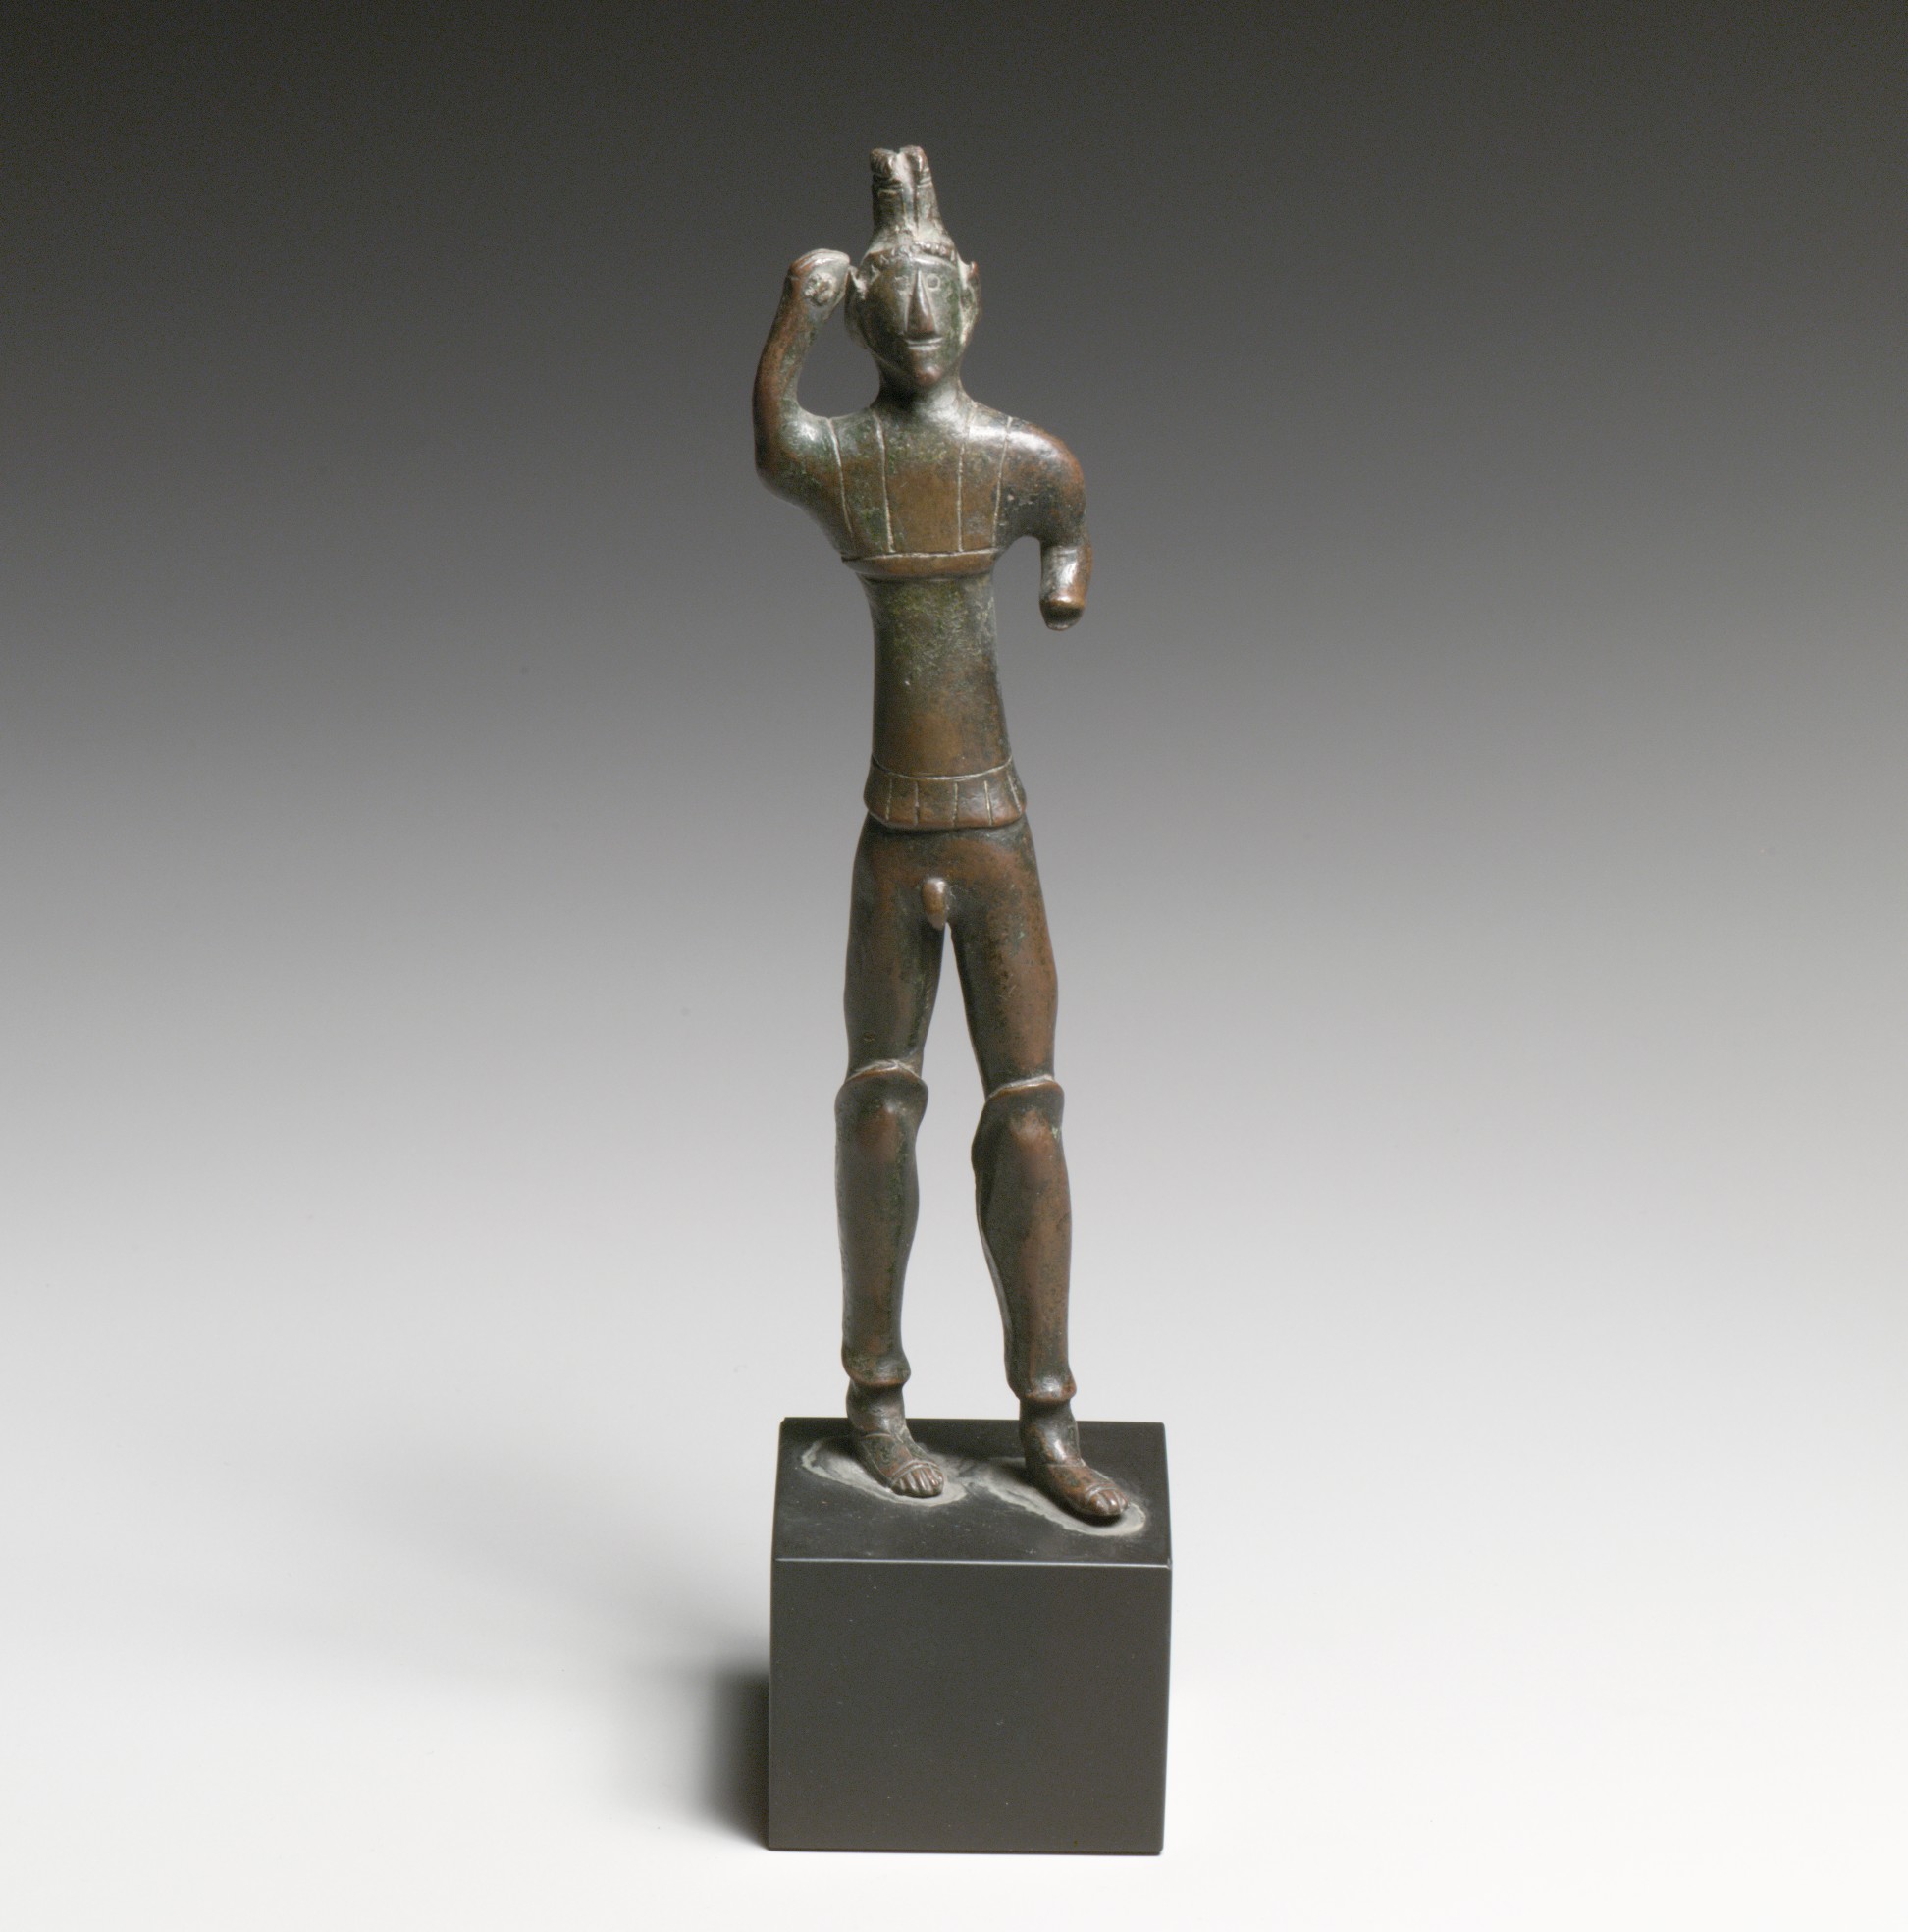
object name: statuette of a warrior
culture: greek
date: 7000-30 BCE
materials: bronze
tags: male nudes,warriors